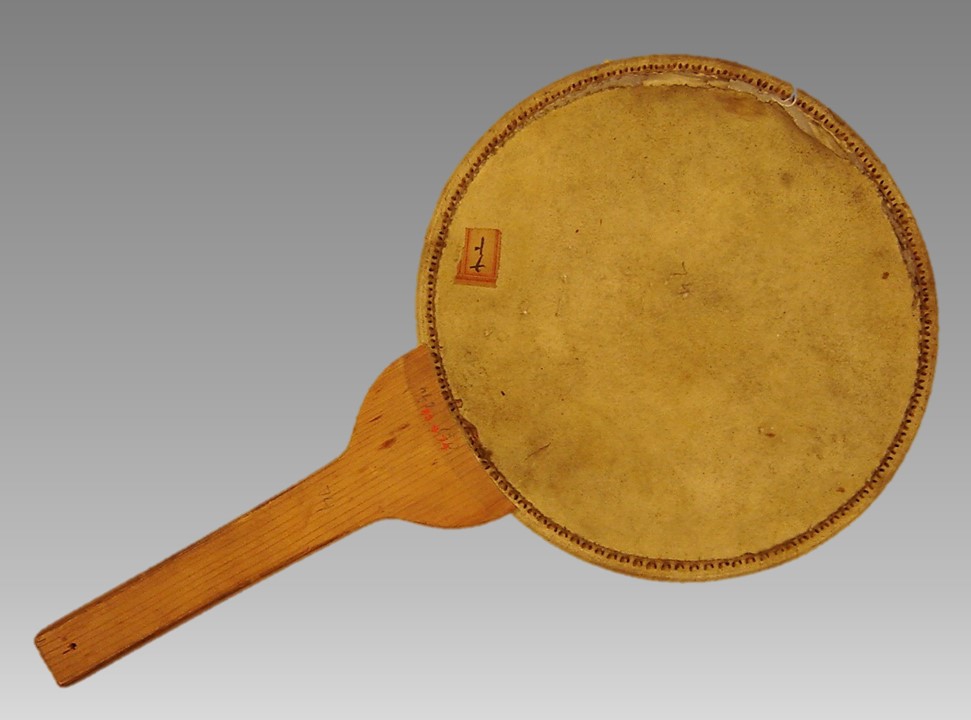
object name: uchiwa daiko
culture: japanese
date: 1801-1900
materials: metal, wood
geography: japan